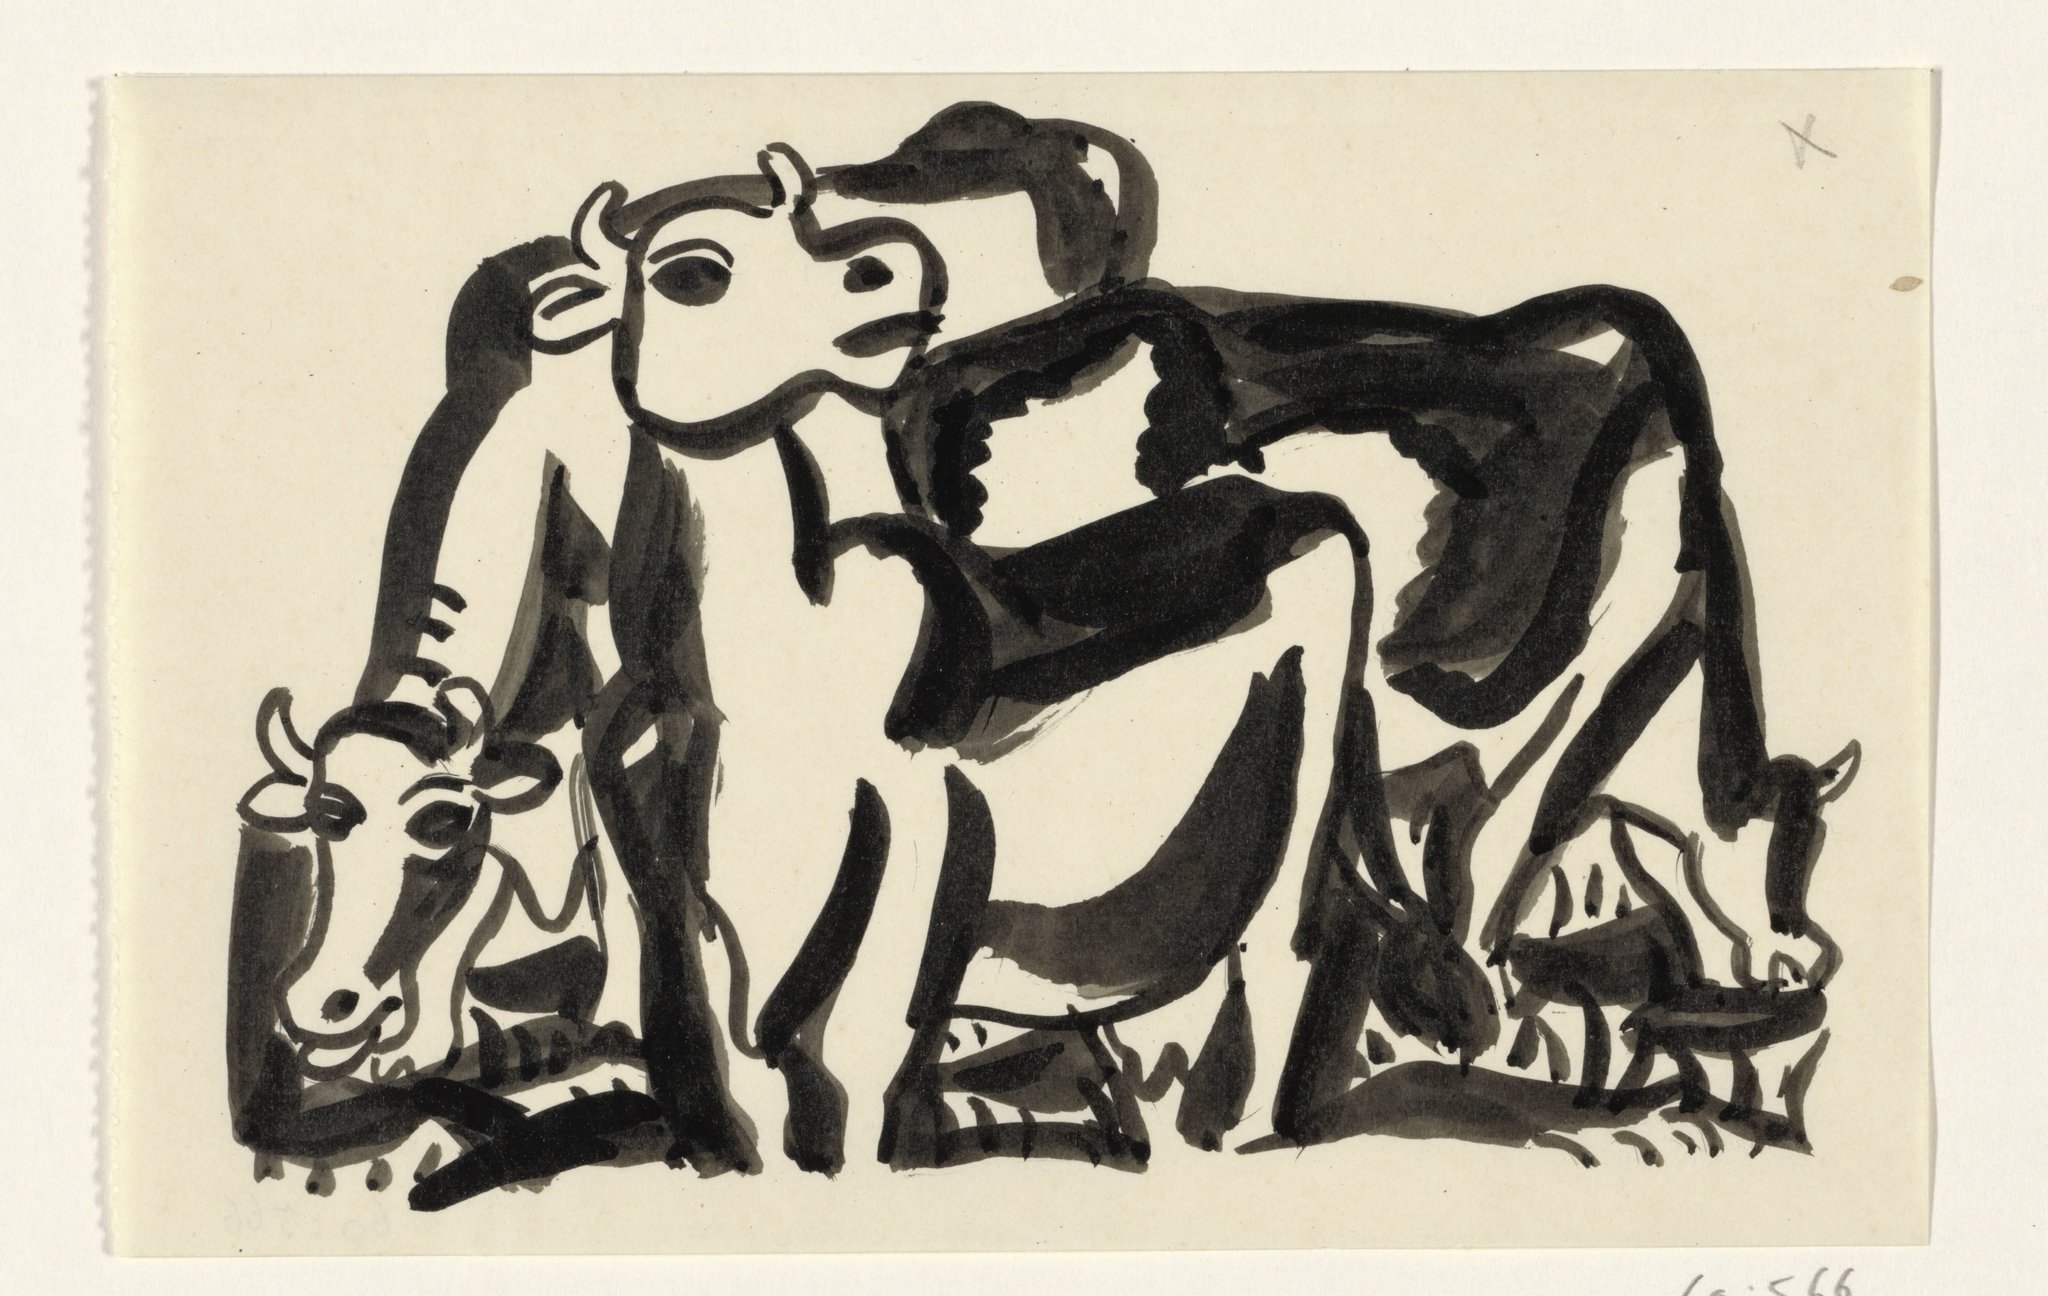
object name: drawing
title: Drie koeien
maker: leo gestel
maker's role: draughtsman, print maker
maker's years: 1881-1941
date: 1891-1941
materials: ink, paper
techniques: brush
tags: cow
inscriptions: collector's mark: Lugt 2228